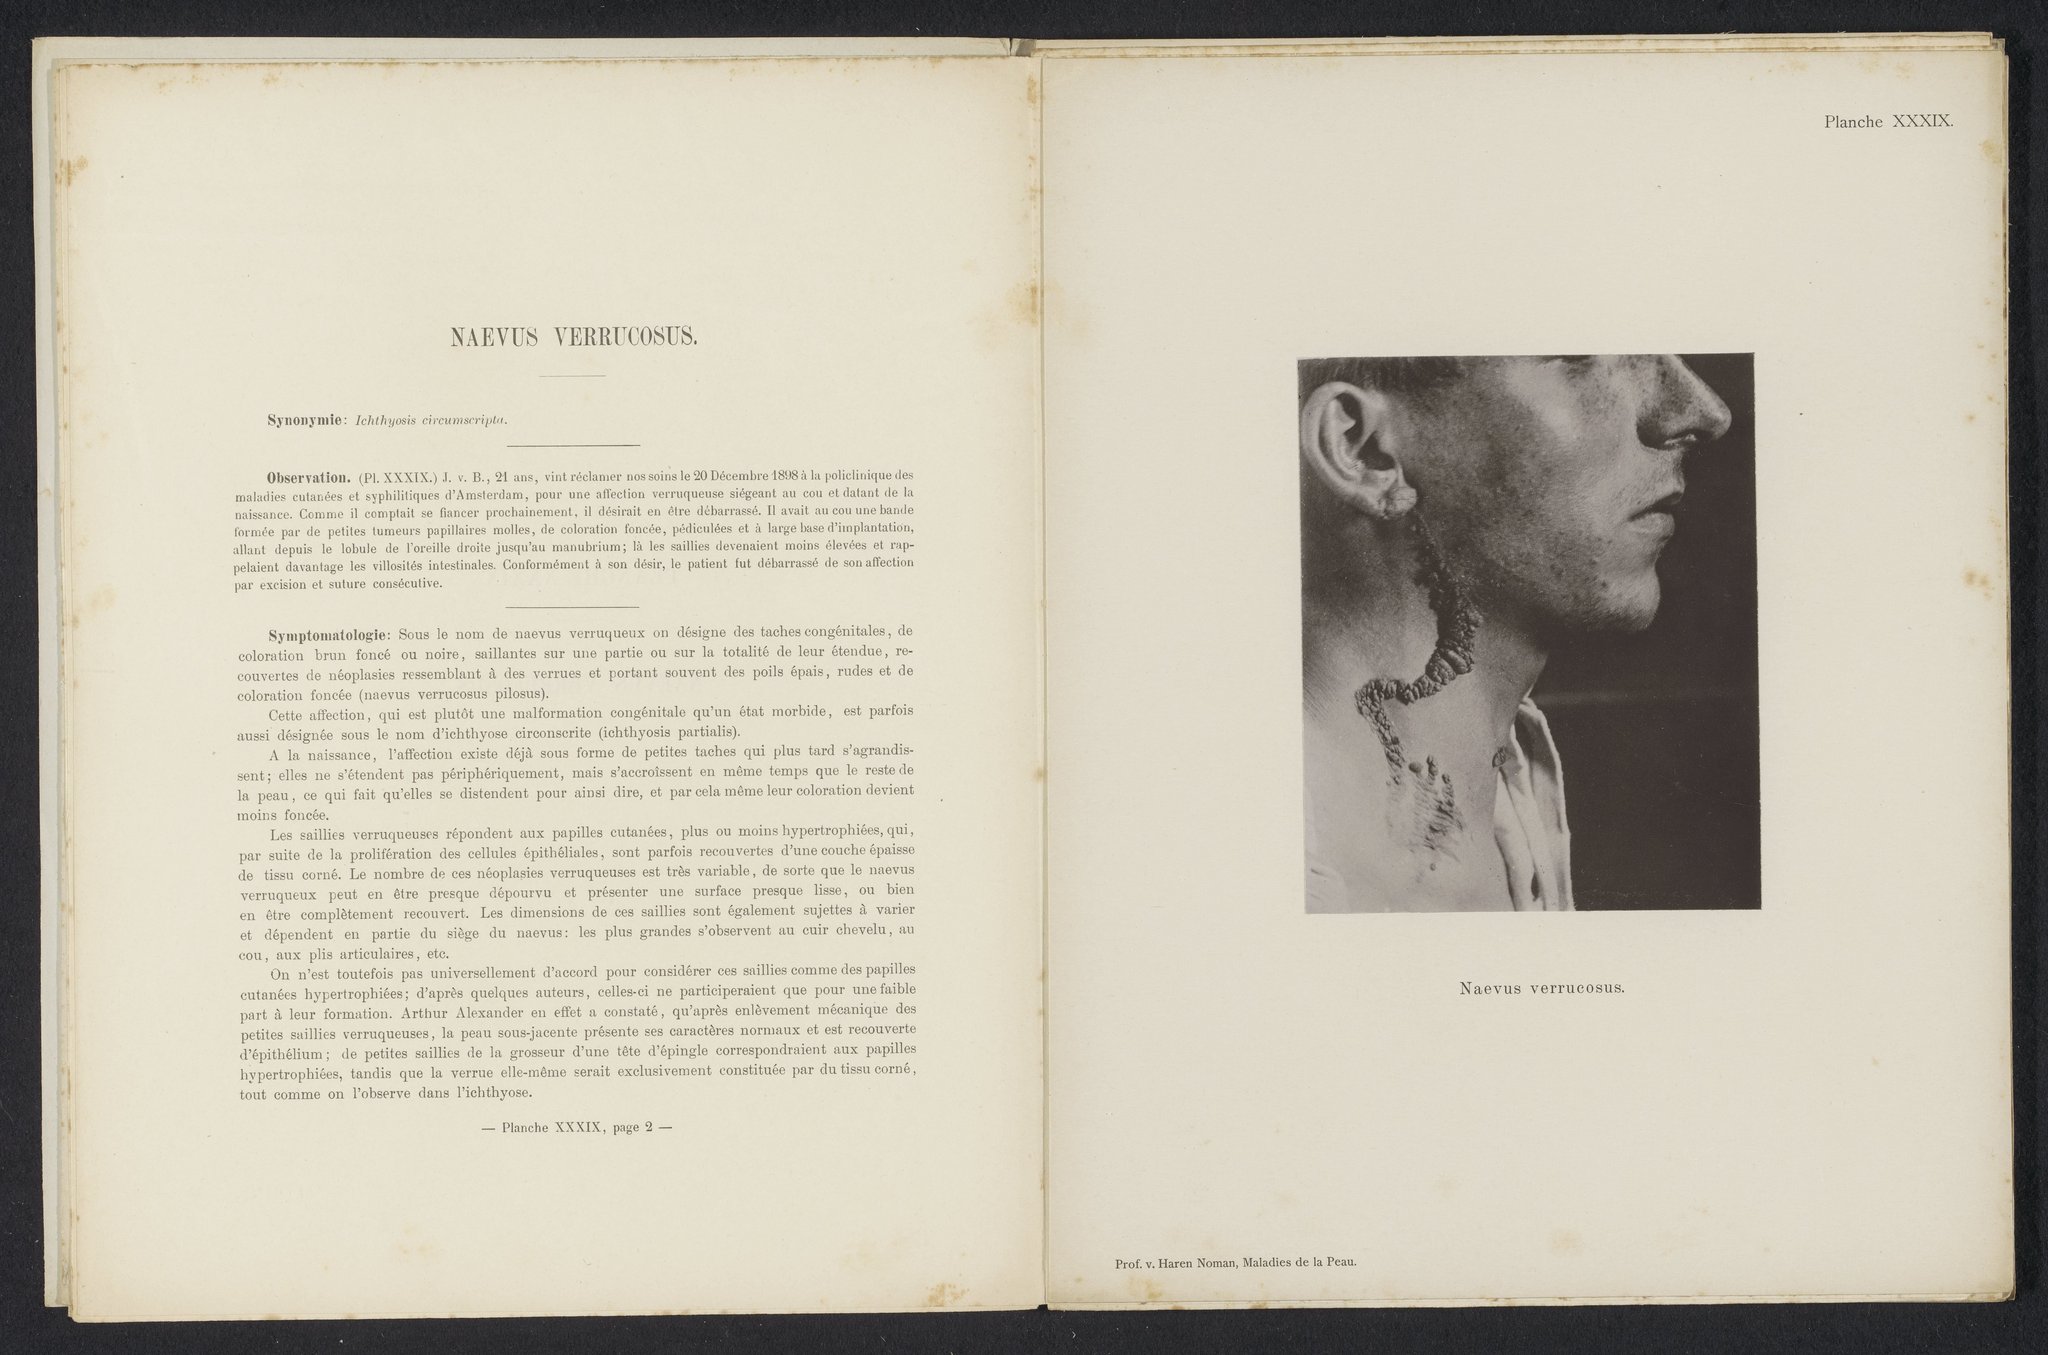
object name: photomechanical print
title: Naevus verrucosus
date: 1890-1900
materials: paper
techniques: photograph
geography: amsterdam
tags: head (human), skin and venereal diseases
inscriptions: number: ‘Planche XXXIX.’